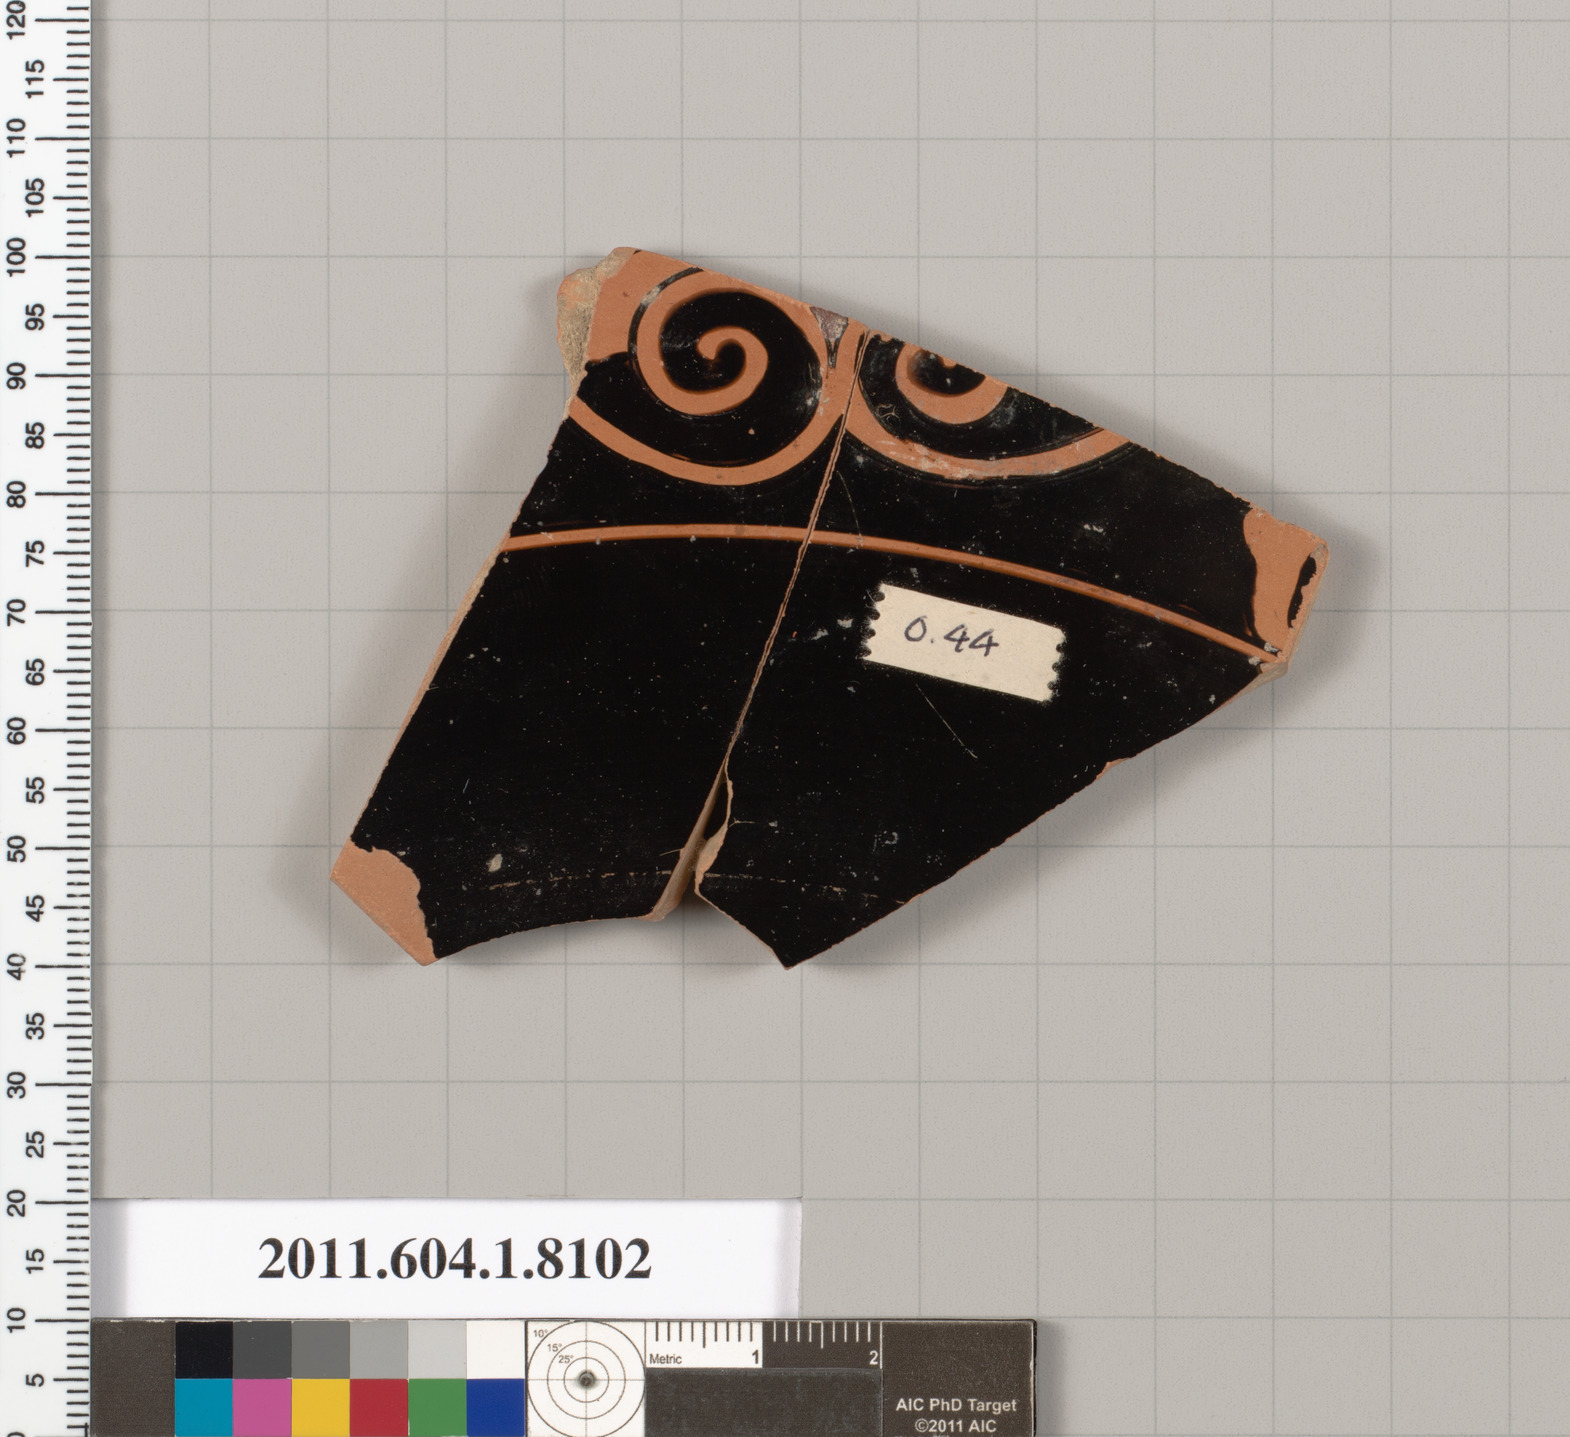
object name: kylix fragment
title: Terracotta fragment of a kylix (drinking cup)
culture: greek, attic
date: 520-510 BCE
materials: terracotta